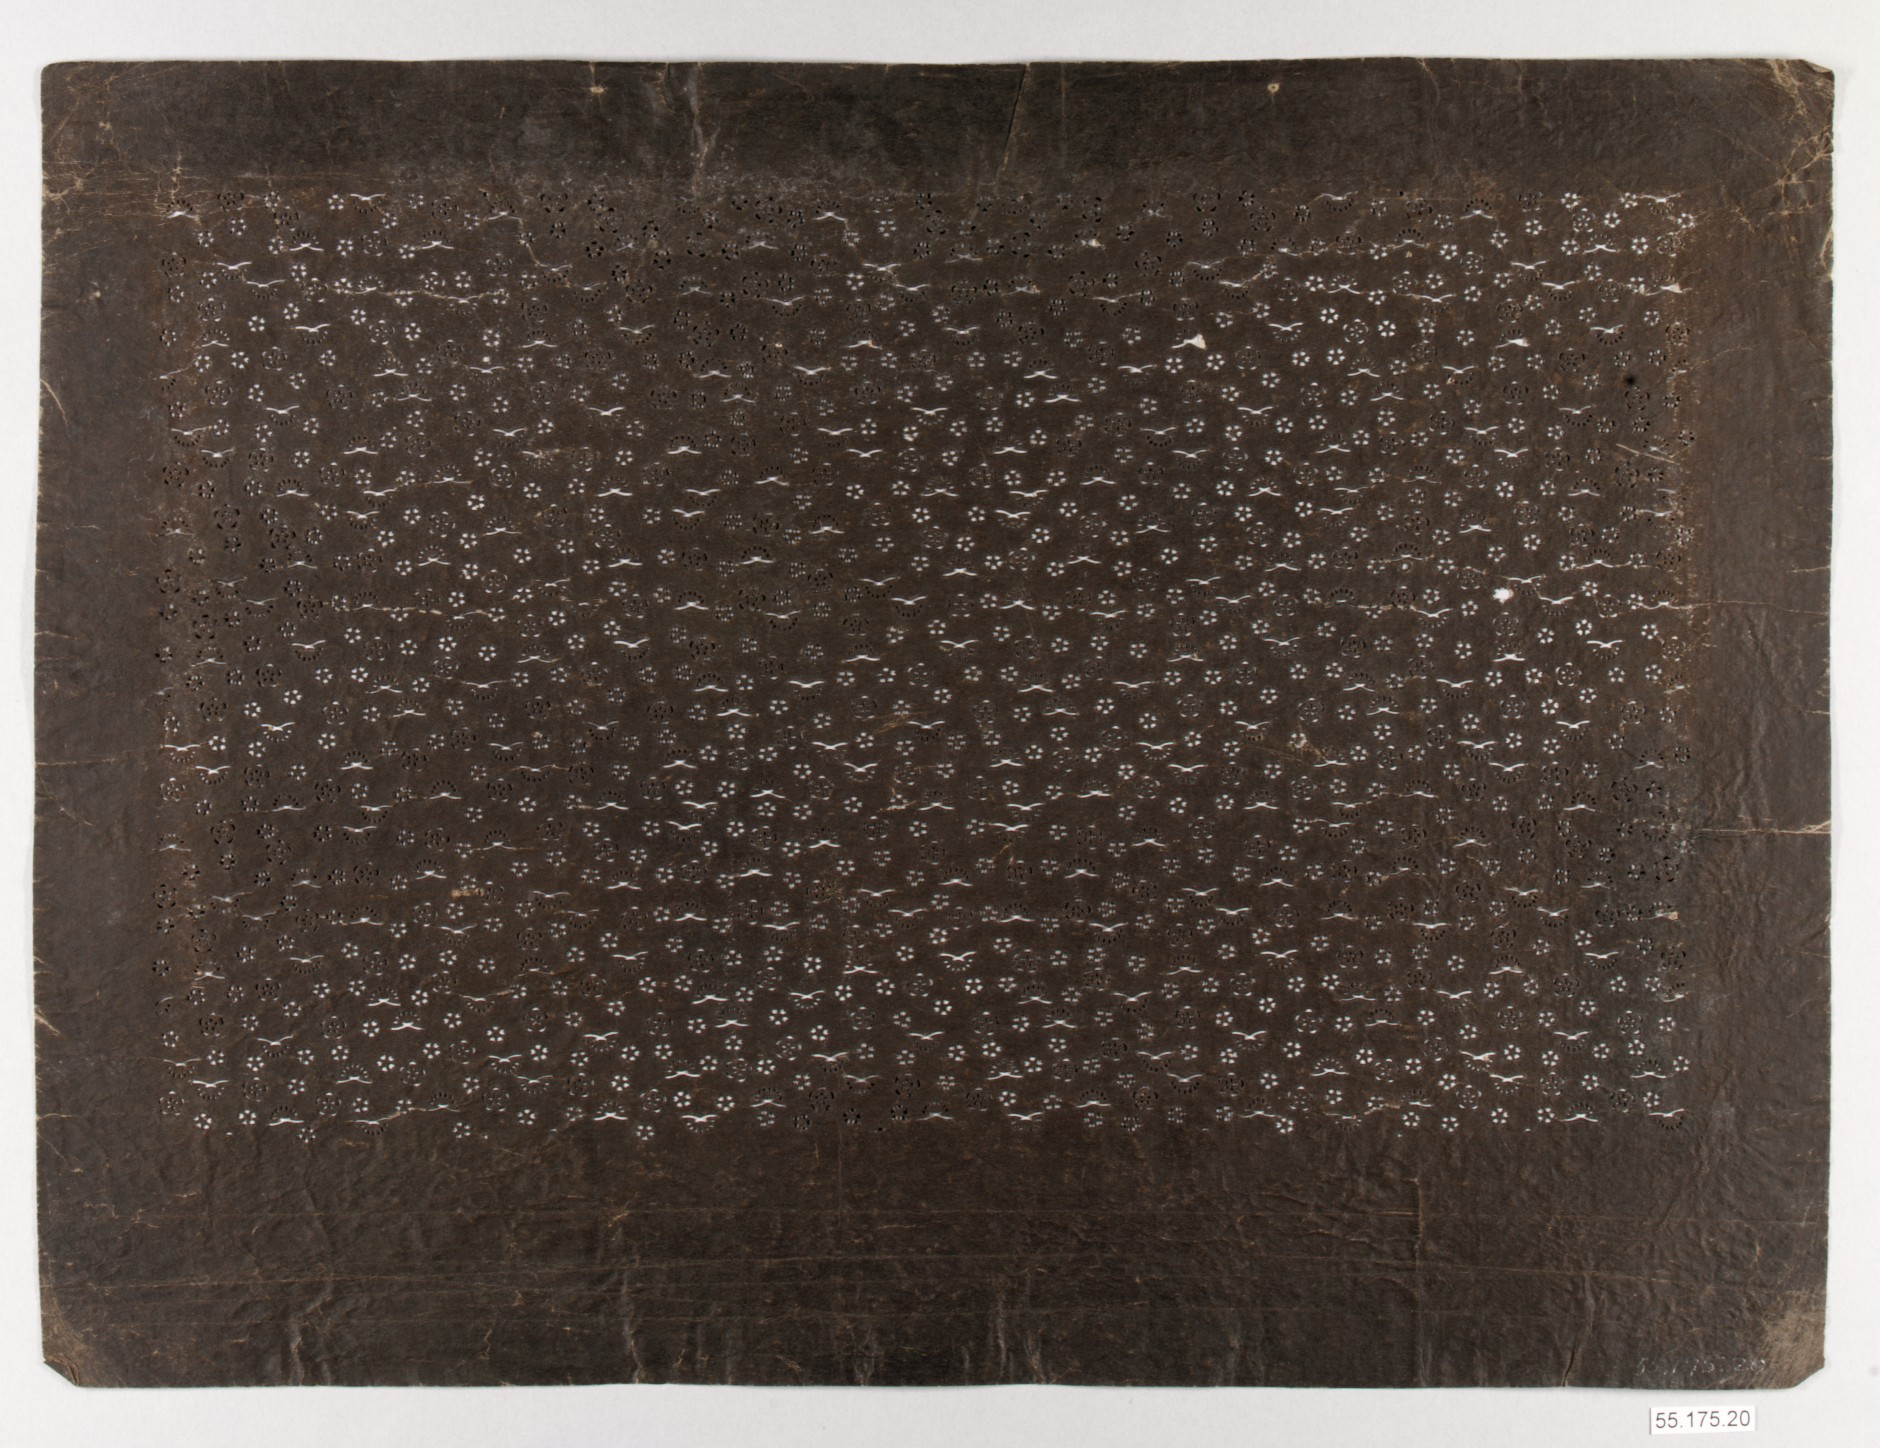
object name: stencil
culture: japanese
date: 1801-1900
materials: paper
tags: flowers